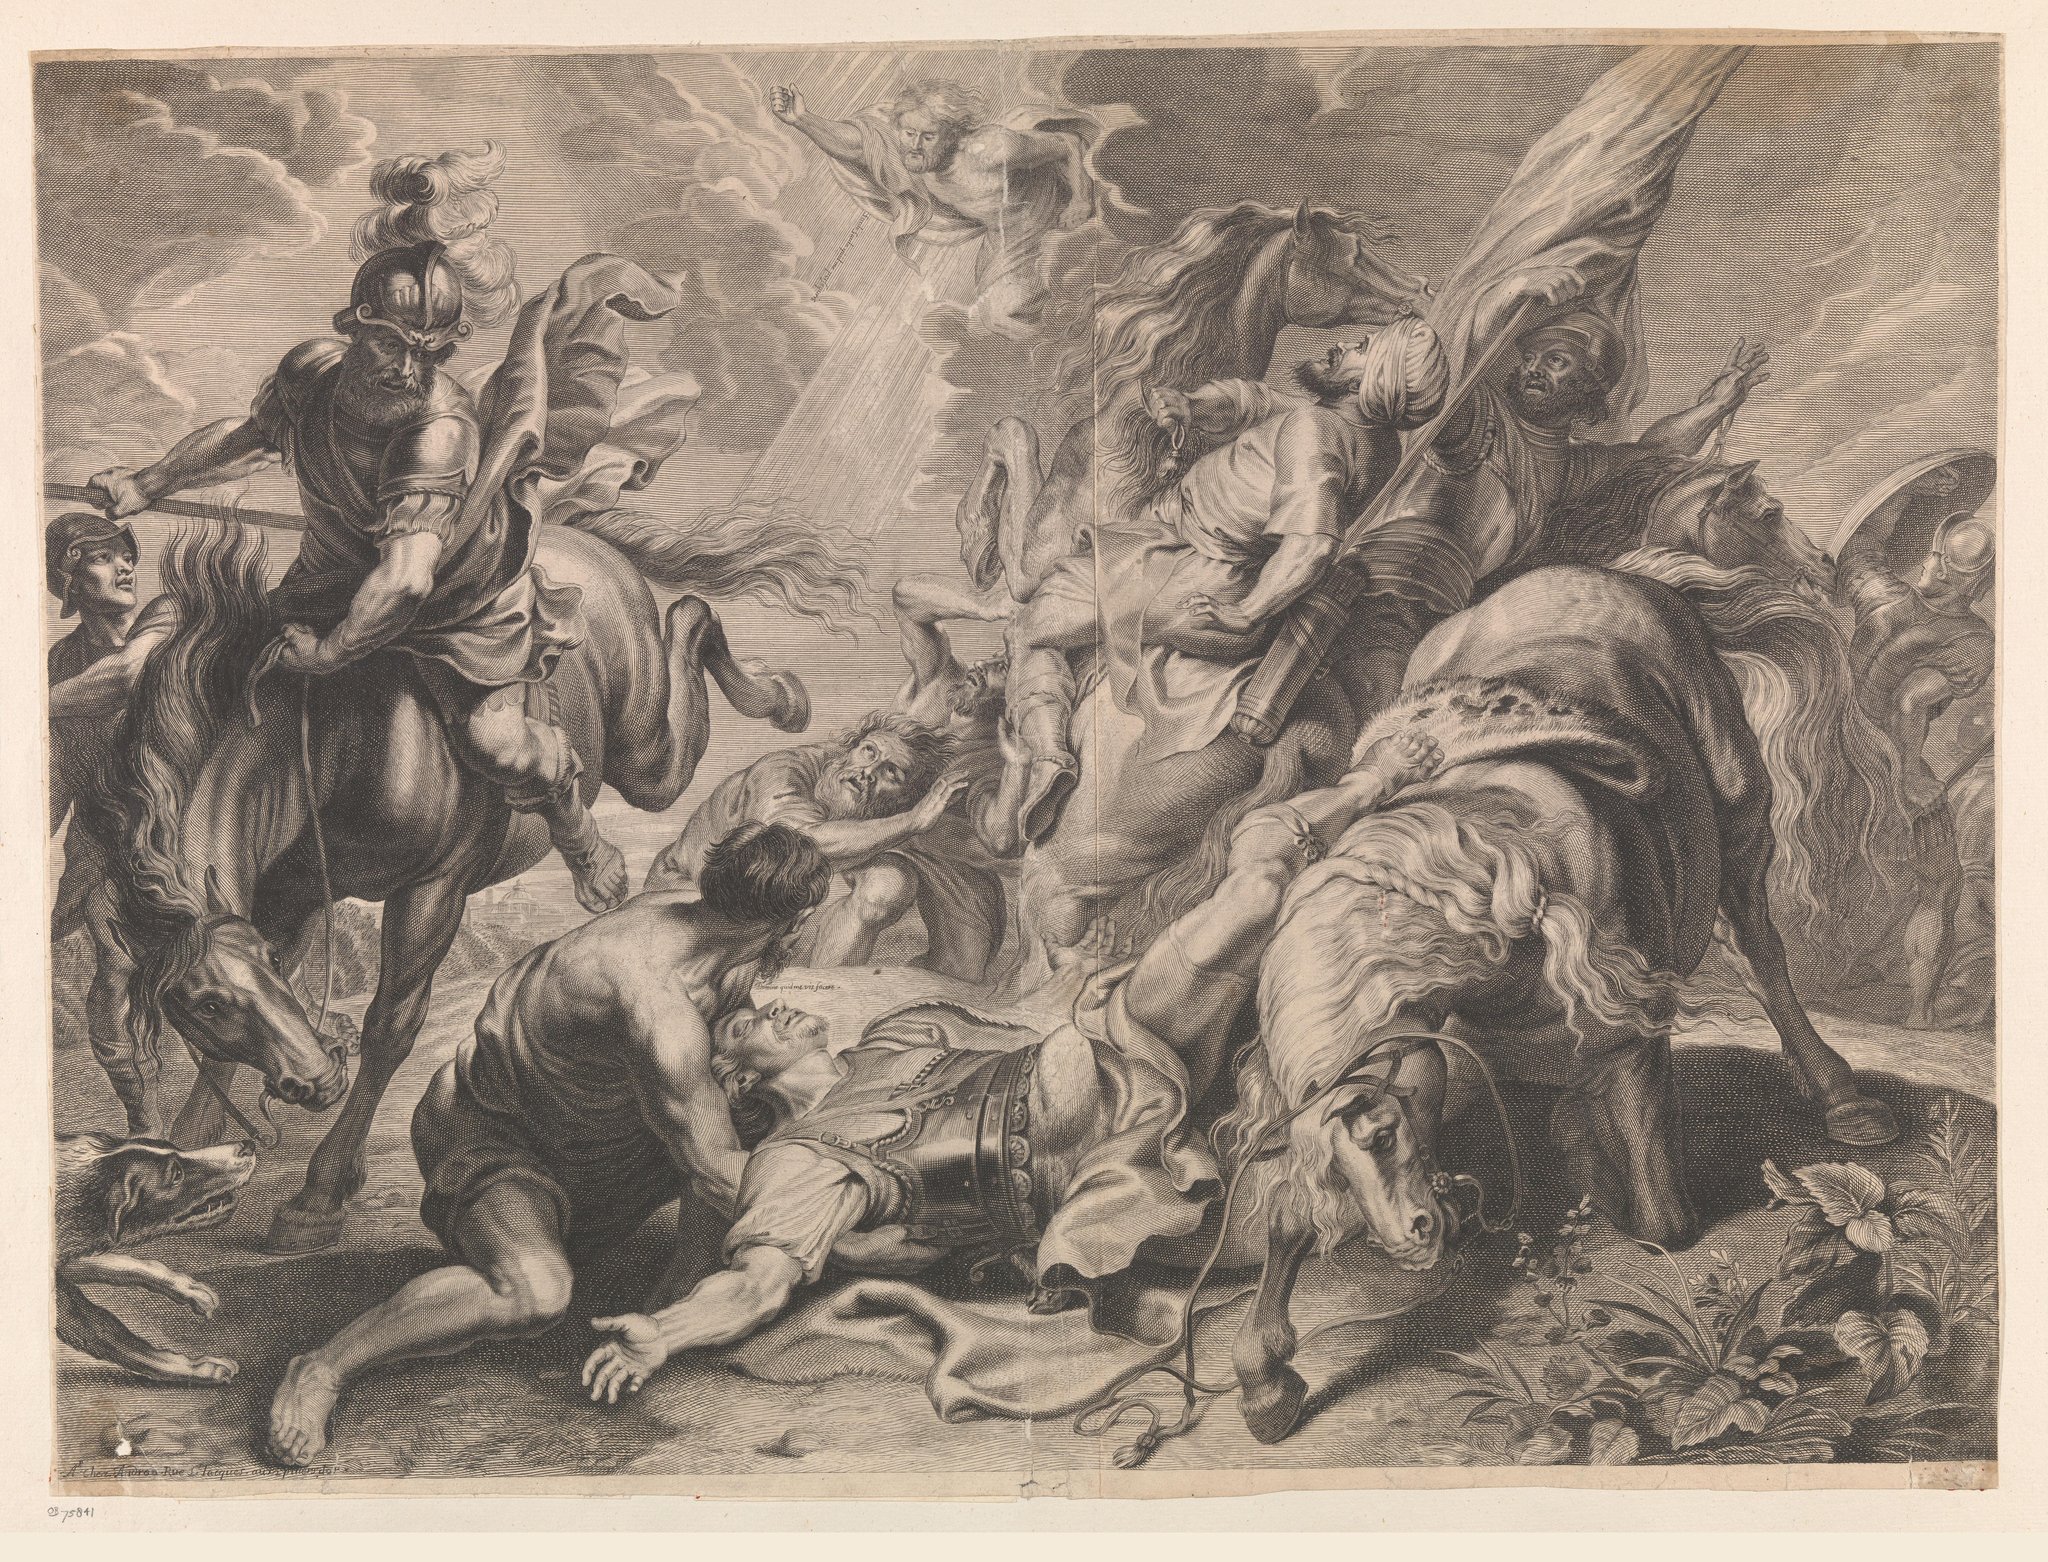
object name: album leaf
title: Bekering van Paulus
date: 1648-1657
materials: paper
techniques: engraving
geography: paris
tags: saul desires letters from the high priest so as to persecute the disciples of the lord in damascus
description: Naar het verloren gegane schilderij van ca. 1620-1629, voorheen in de Gemäldegalerie, Berlin. Zie het exemplaar in de collectie van het V&A in Londen, met naam onderschrift en naam van de graveur. Spiegelbeeldige kopie naar de prent van Schelte Adamsz. Bolswert (Hollstein Dutch 196).